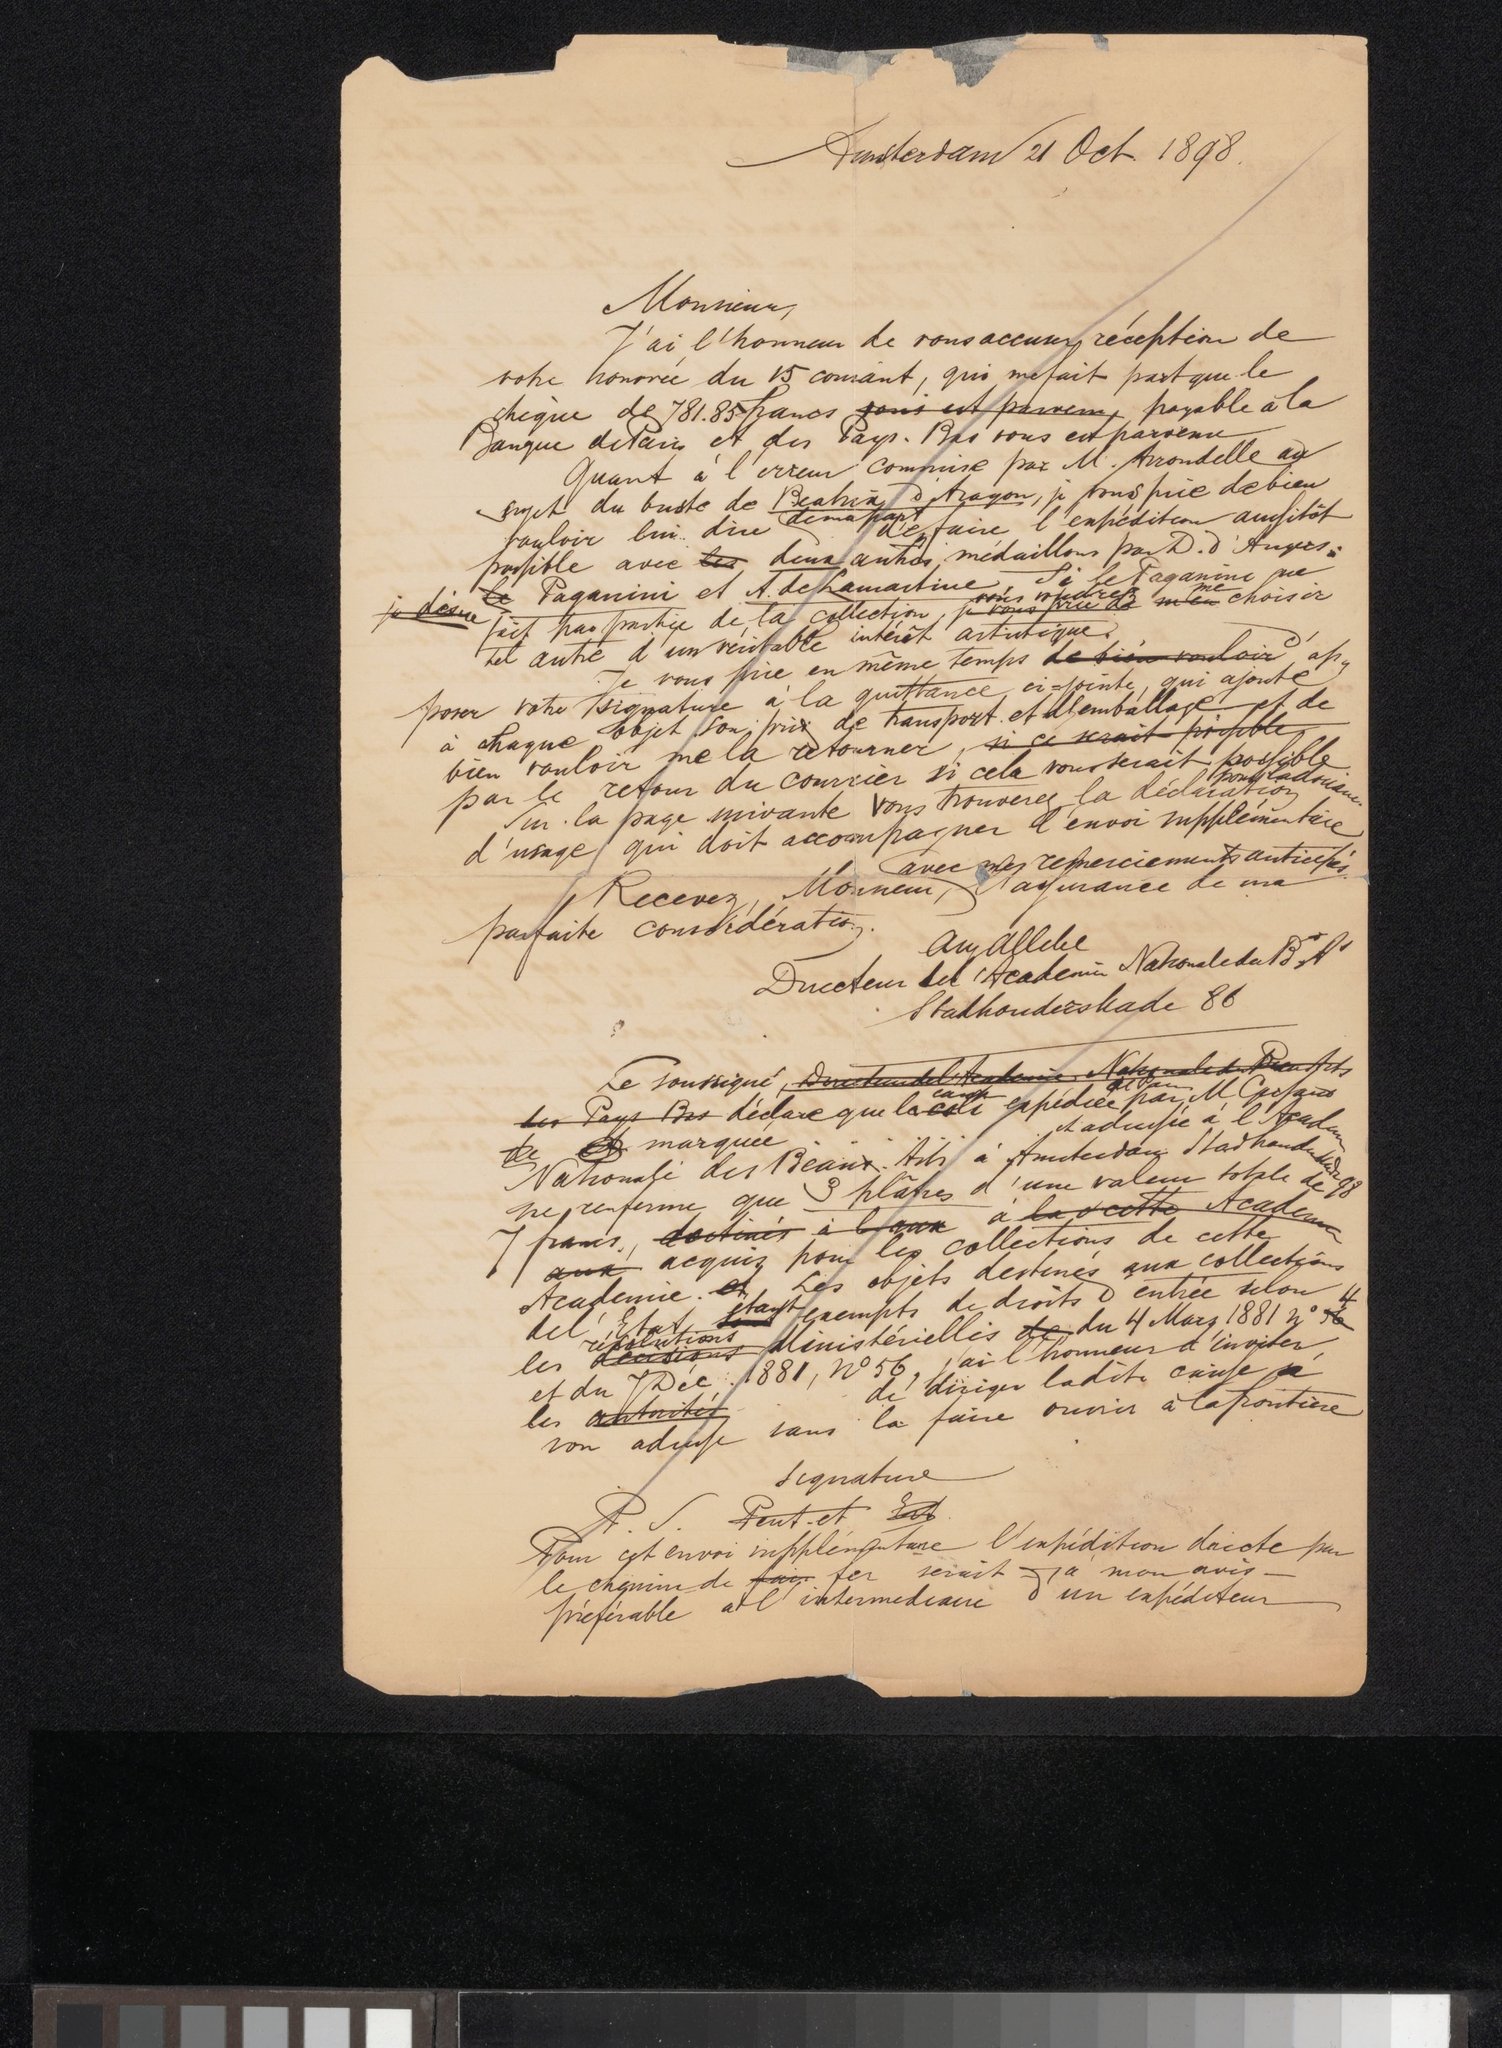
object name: letter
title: Conceptbrieven aan anonieme personen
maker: august allebé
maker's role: draughtsman, print maker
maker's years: 1838-1927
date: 1898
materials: ink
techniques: pen, writing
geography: amsterdam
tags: salomon garf, paris, sculptor, pierre jean david d'angers, sculpture, education, tuition of the artist (in general), money